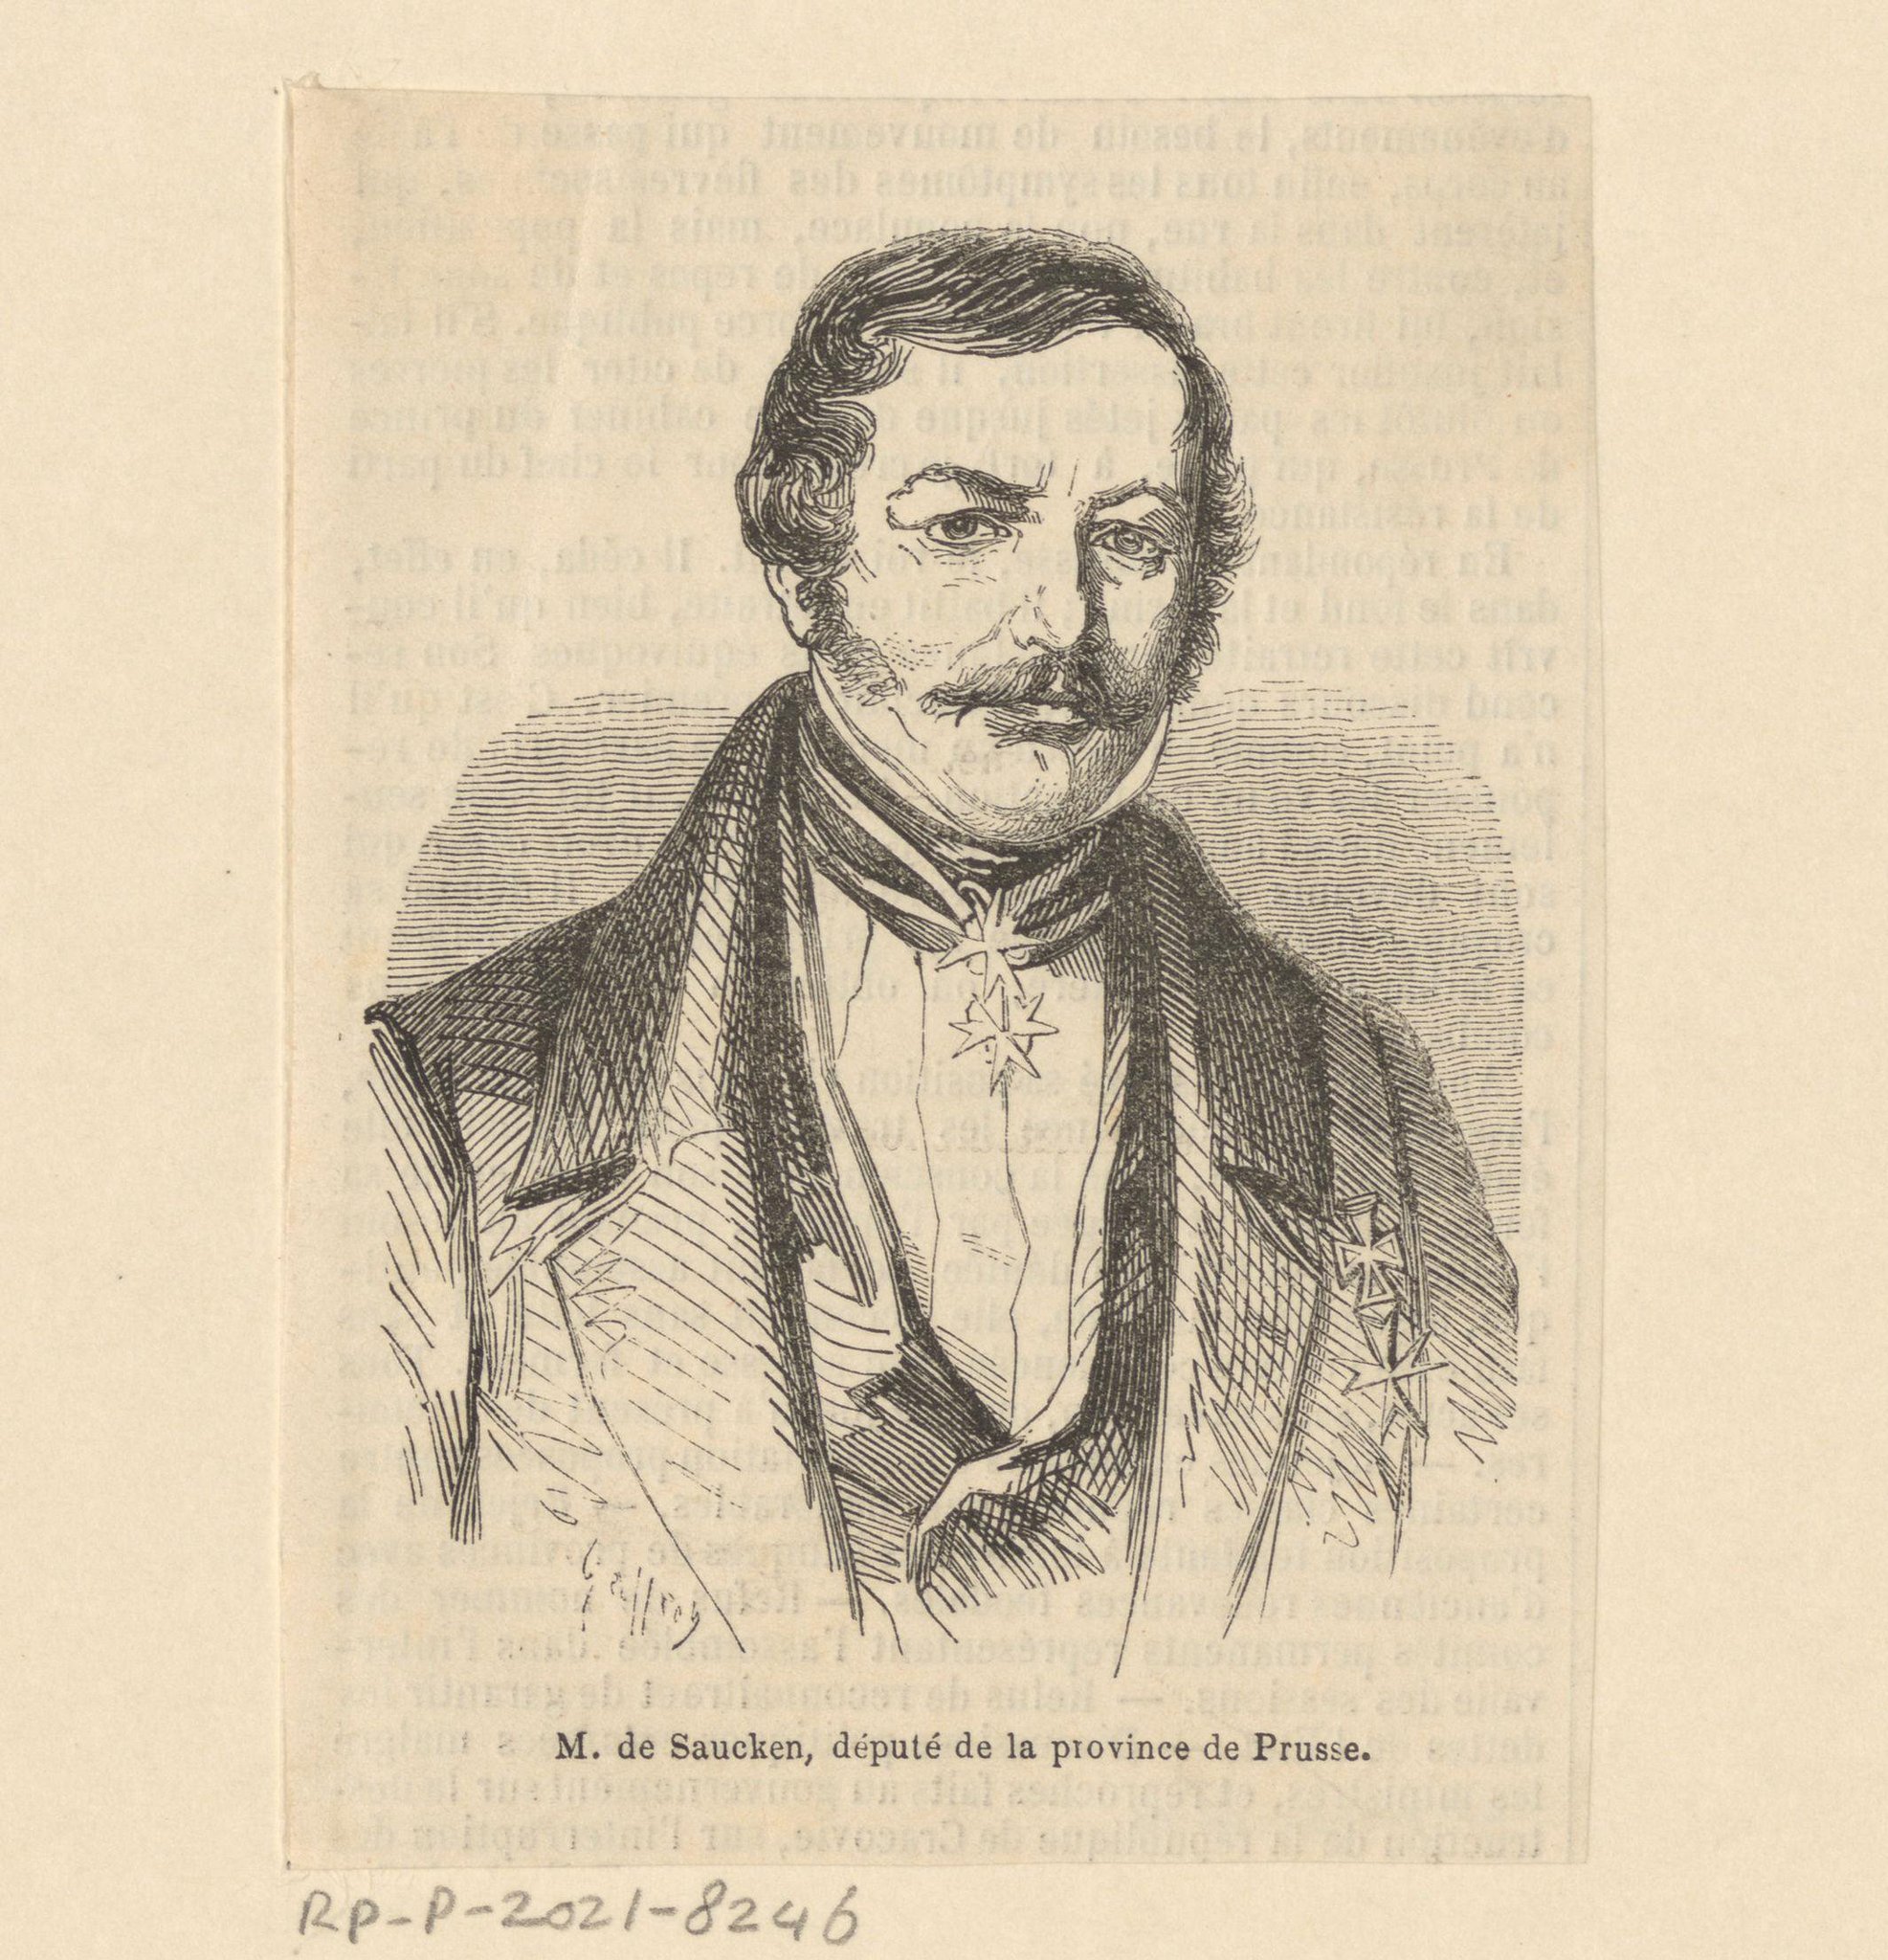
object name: print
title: Portret van Ernst von Saucken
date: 1847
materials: paper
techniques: letterpress printing, engraving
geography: paris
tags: politician, historical persons, politician, e.g. party leader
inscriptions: monogram: ‘Gall[...]y’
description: Prent uit: L'Illustration 9 (1847), nr. 224, 12 juni 1847, p. 229.